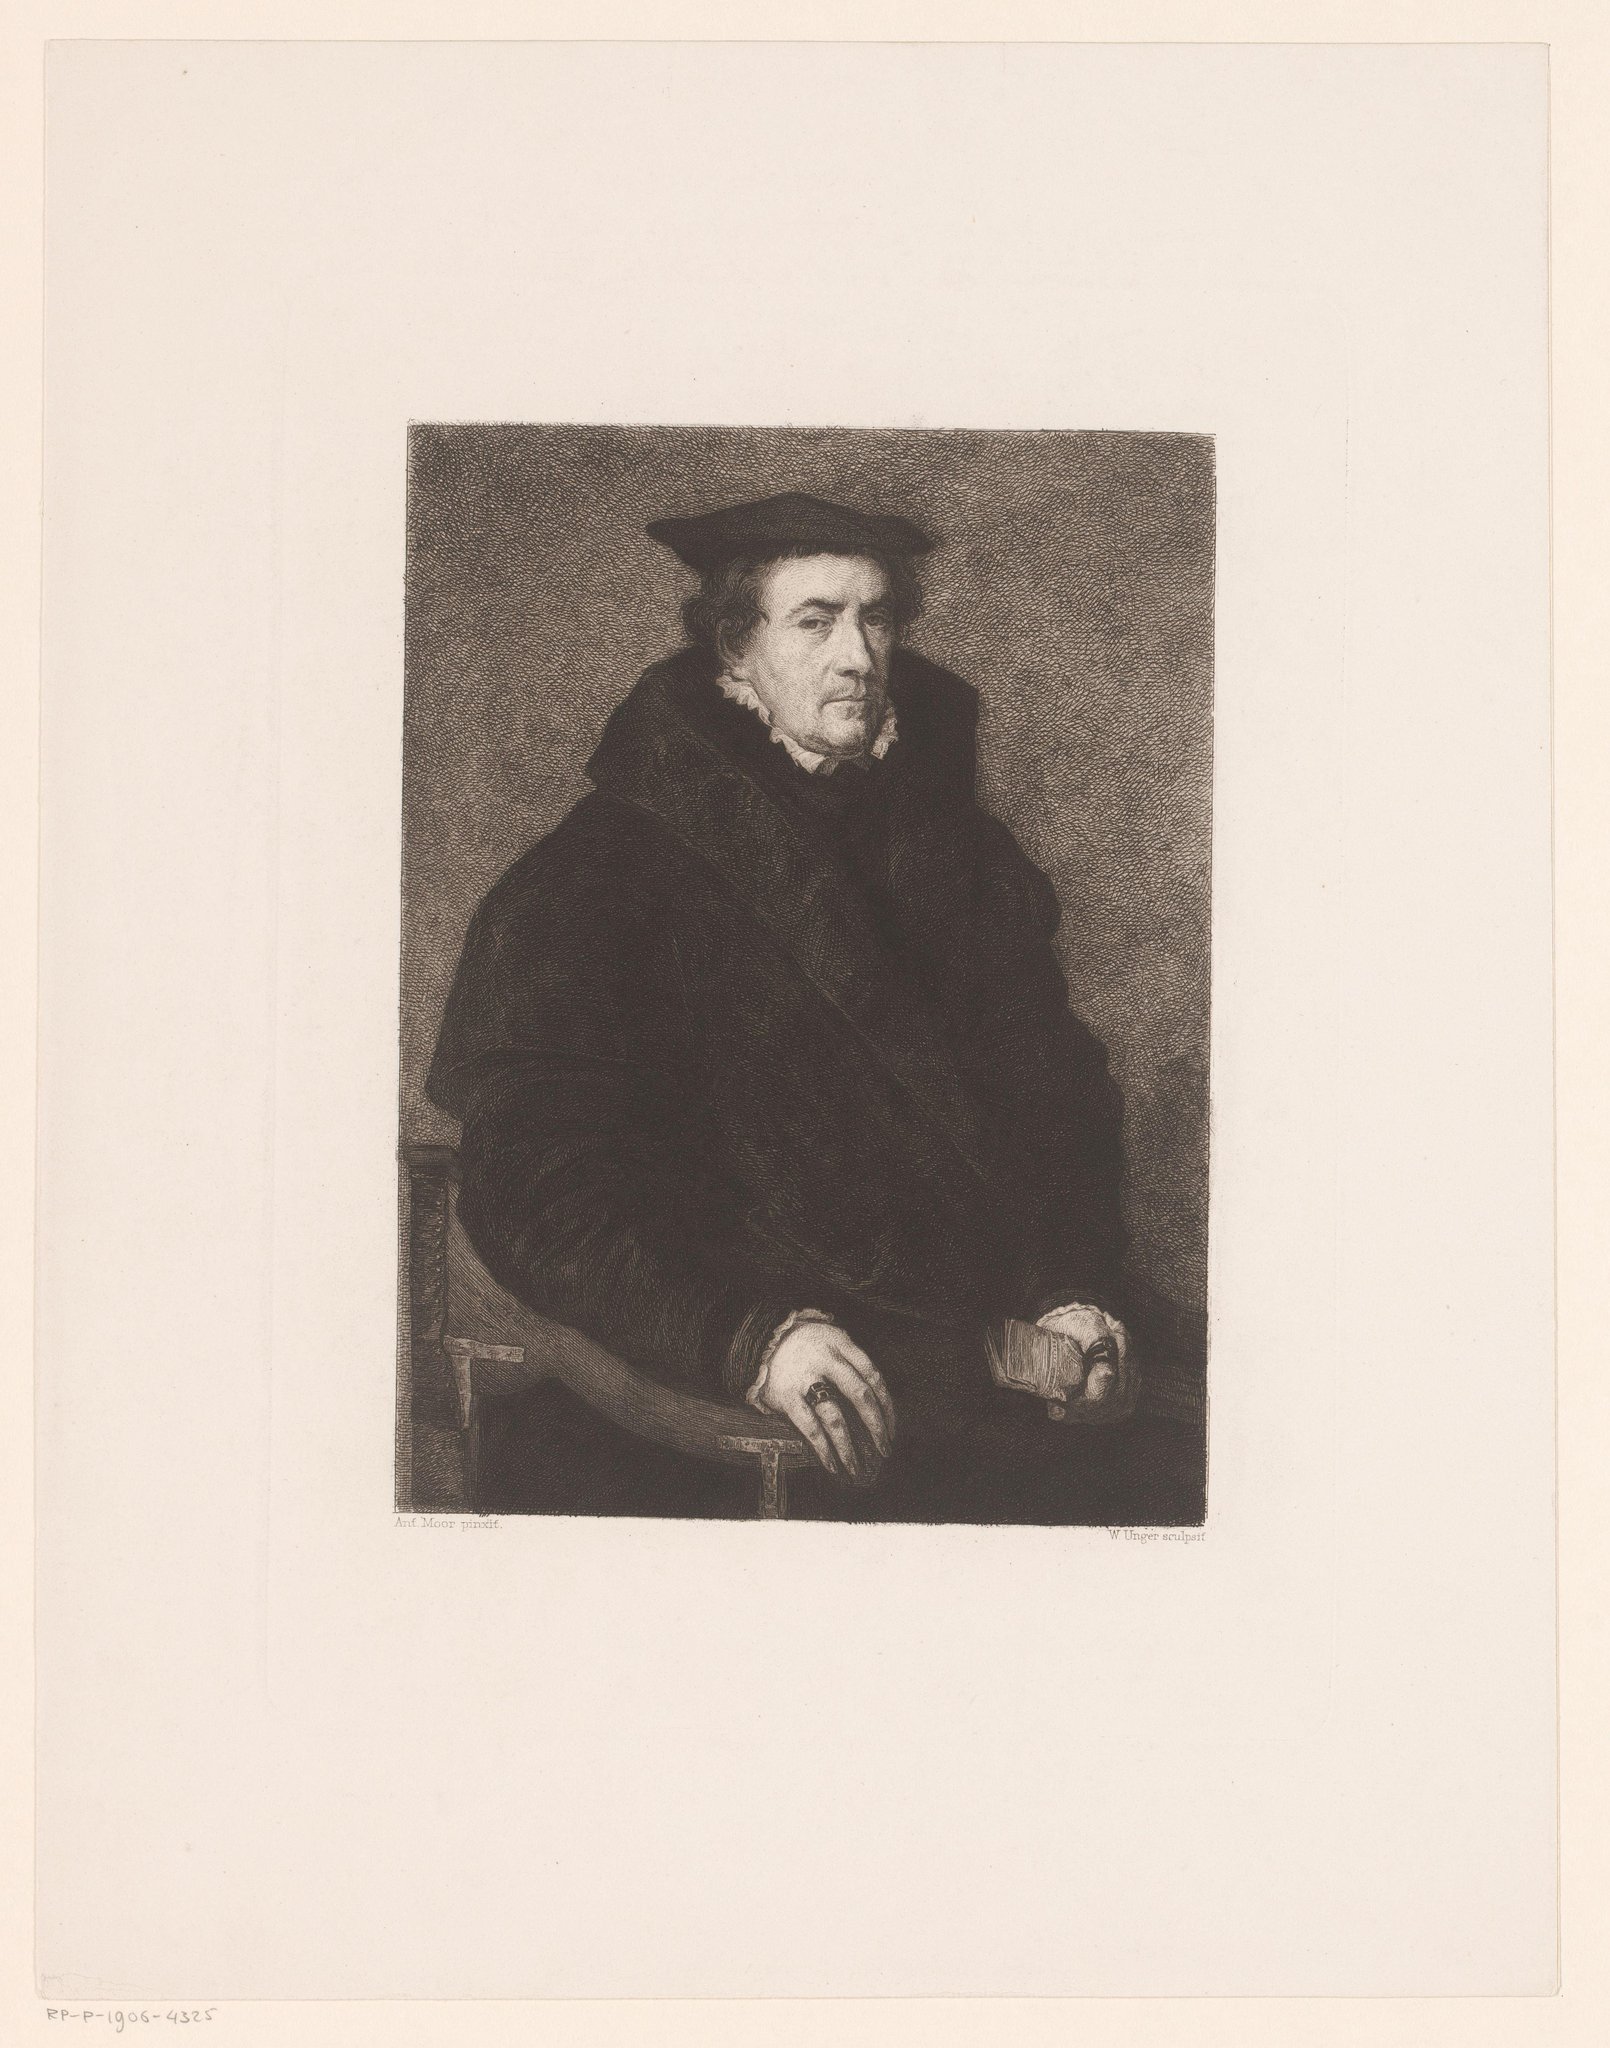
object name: print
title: Portret van een onbekende man met handschoen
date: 1847-1906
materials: paper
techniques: etching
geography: germany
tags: gloves, mittens, etc., historical persons, chair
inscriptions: collector's mark: Lugt 2228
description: Prent naar het schilderij door Anthonis Mor in het Herzog Anton Ulrich-Museum te Braunschweig (inv.nr. 38).